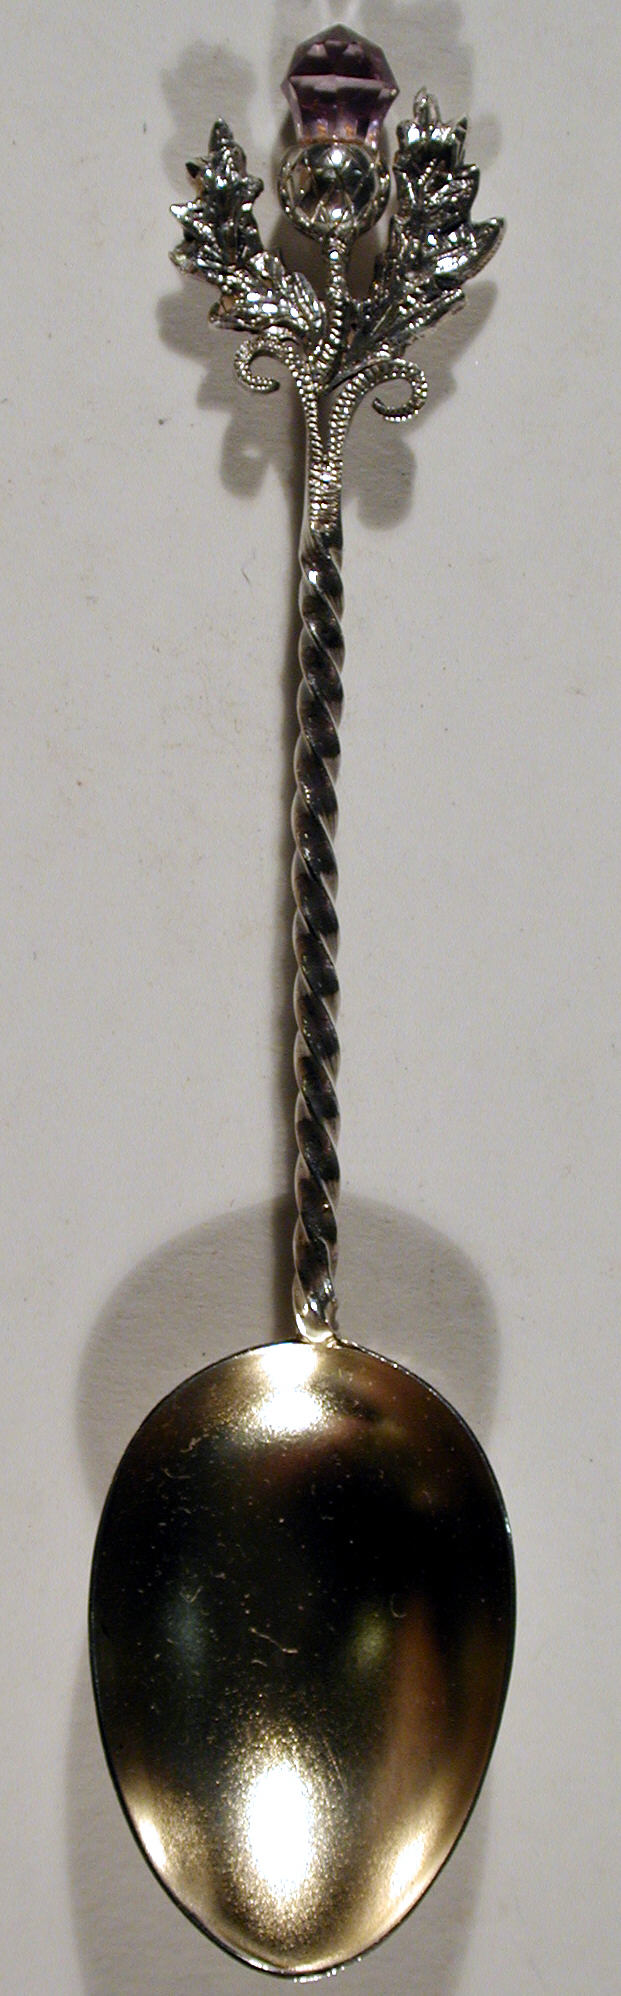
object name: souvenir spoon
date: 1896-1897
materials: gemstone, gilt, silver